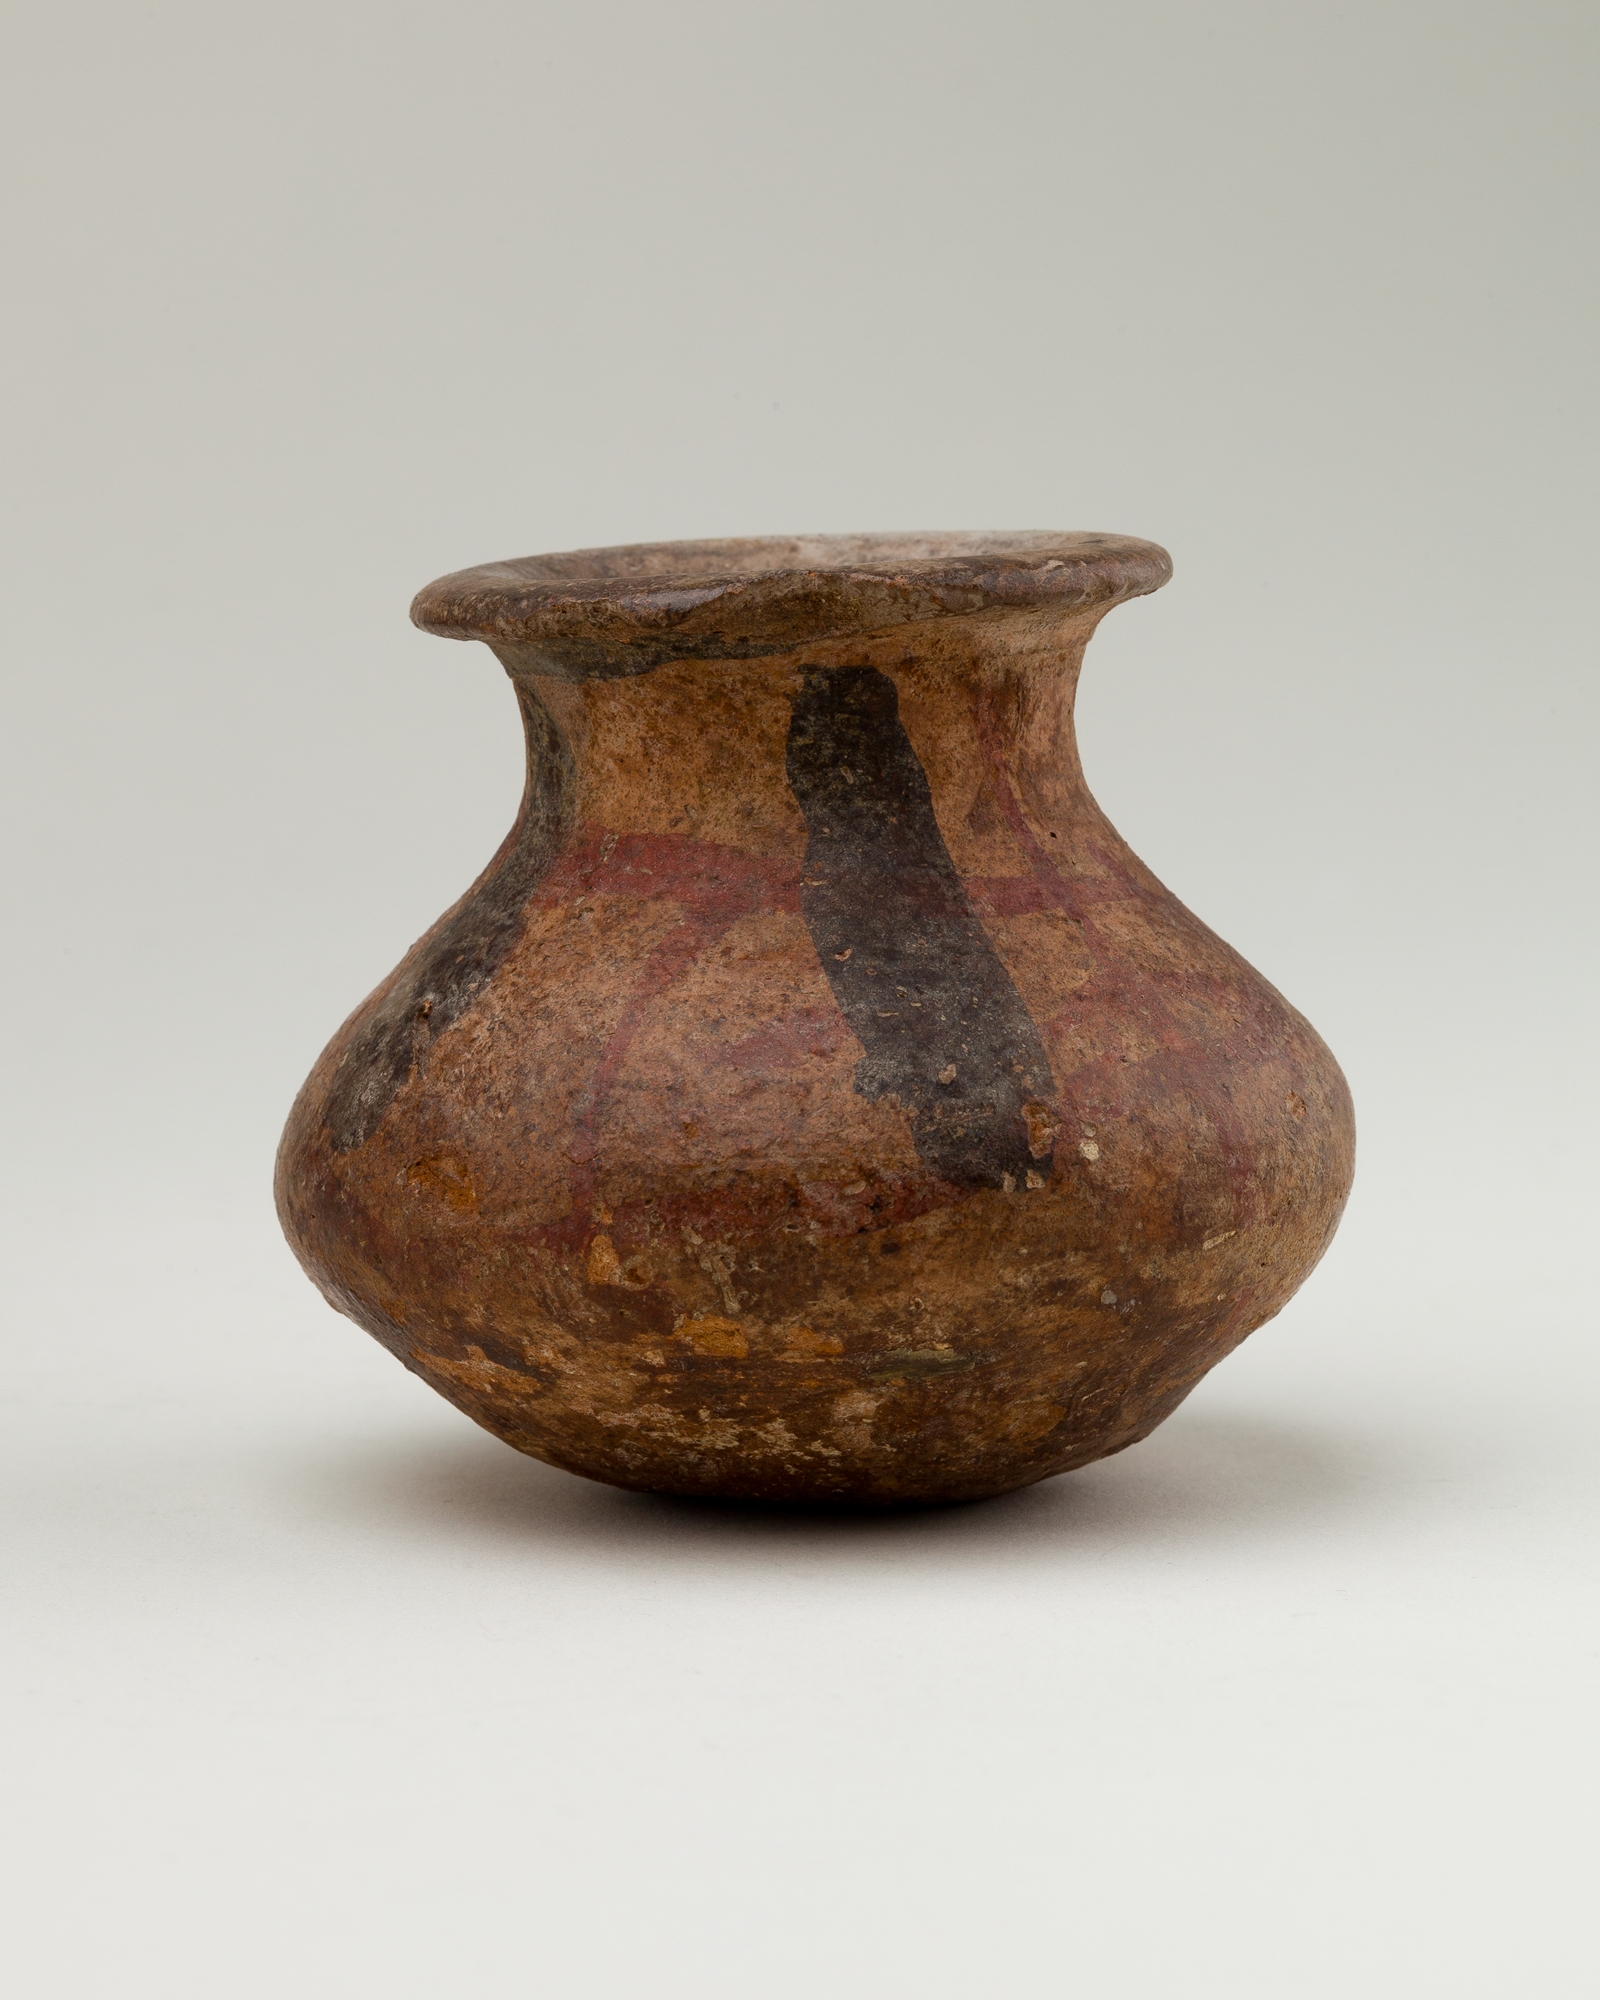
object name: jar, painted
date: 1500-1400 BCE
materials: paint, pottery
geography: egypt